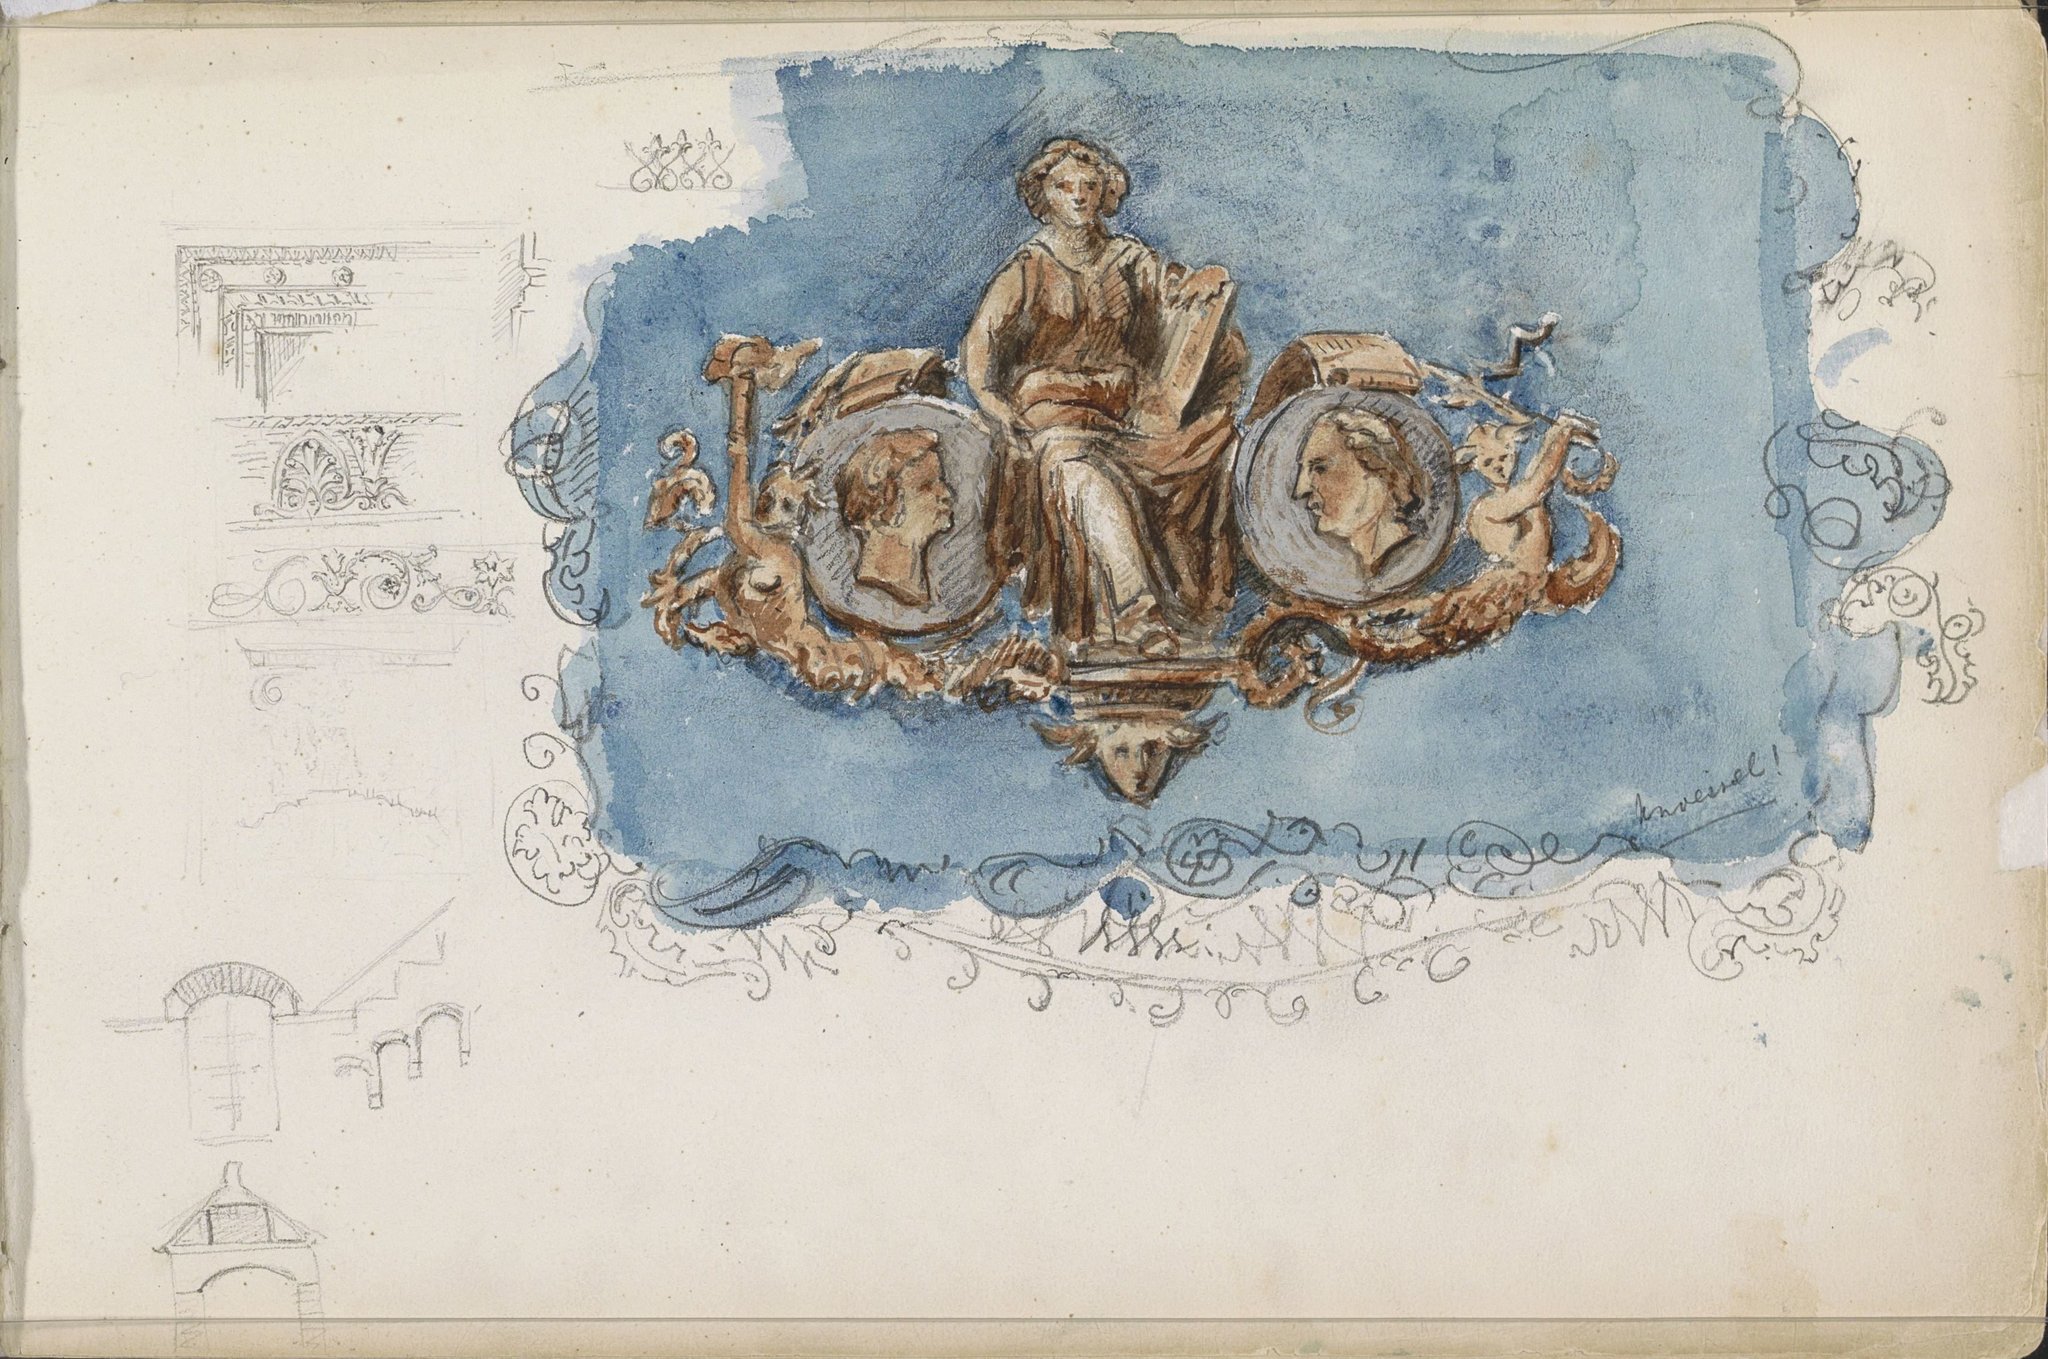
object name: sketchbook leaf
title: Vignet met zittende vrouw en twee portretten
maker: isaac gosschalk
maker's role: draughtsman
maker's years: 1838-1907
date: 1862-1867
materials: paper, pencil, watercolor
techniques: brush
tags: ornaments ~ art, architectural detail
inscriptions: annotation: ‘[...]nveisel!’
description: Zittende vrouw, aan weerszijden geflankeerd door portretten van een man en vrouw. Tevens studies van architectonische details. Blad 3 recto uit een schetsboek met 58 bladen.